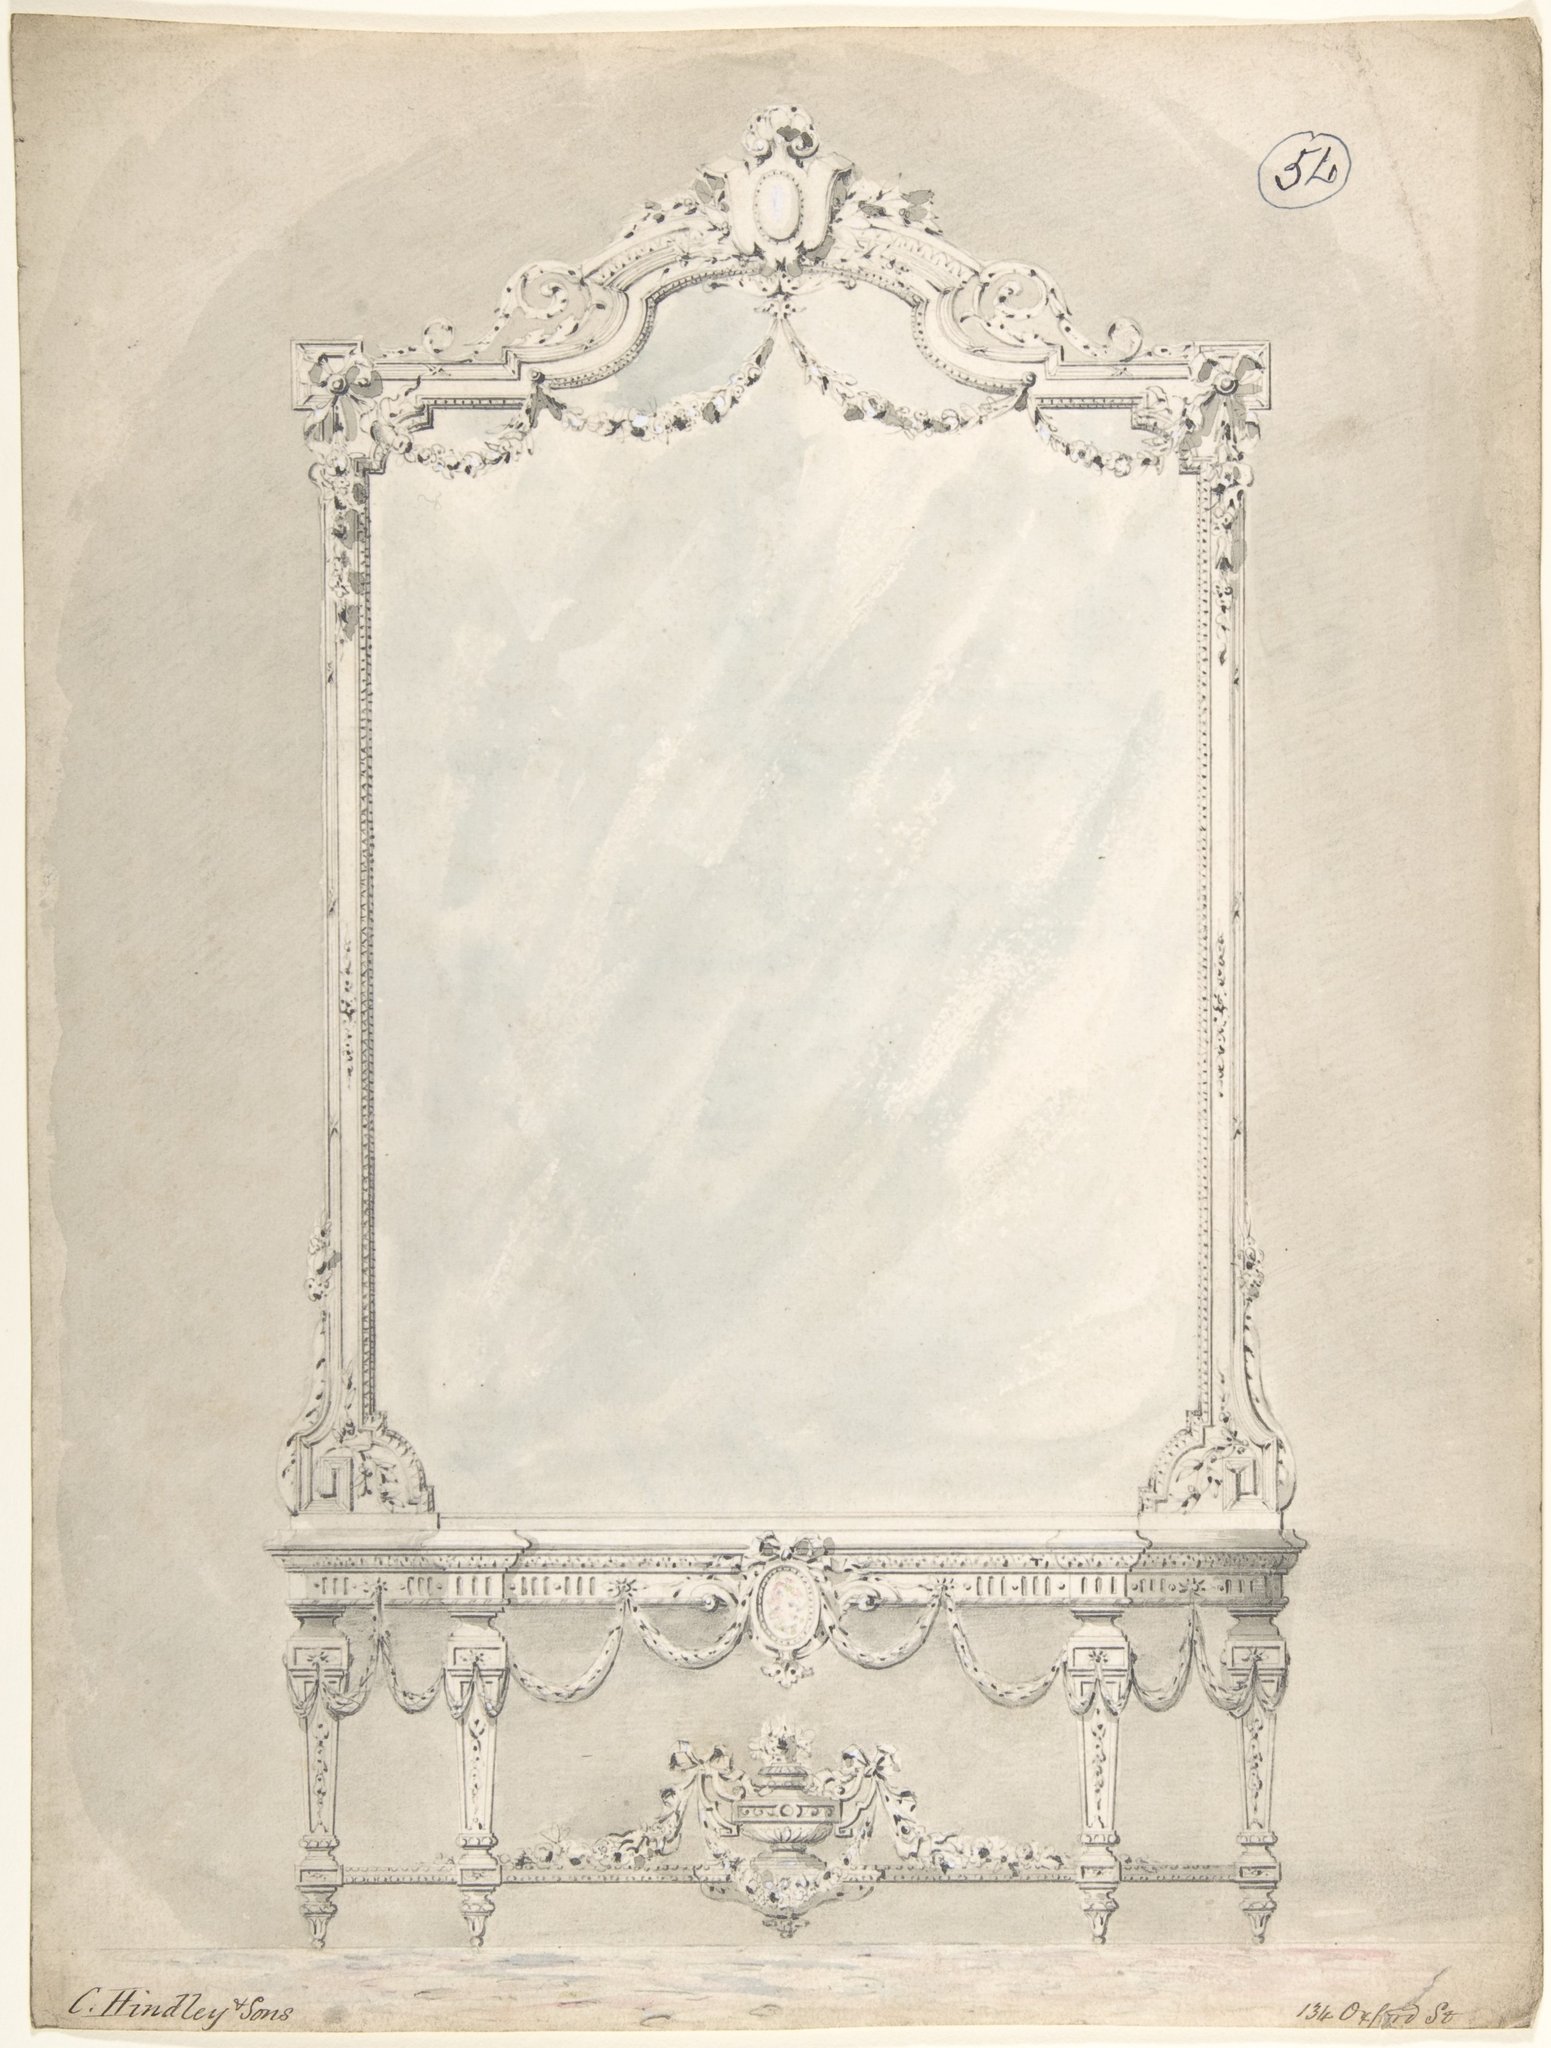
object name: drawing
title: Design for a Side Table and Mirror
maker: charles hindley and sons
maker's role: artist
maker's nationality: british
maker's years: 1841-1917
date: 1841-1884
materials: graphite, watercolor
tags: garlands,tables